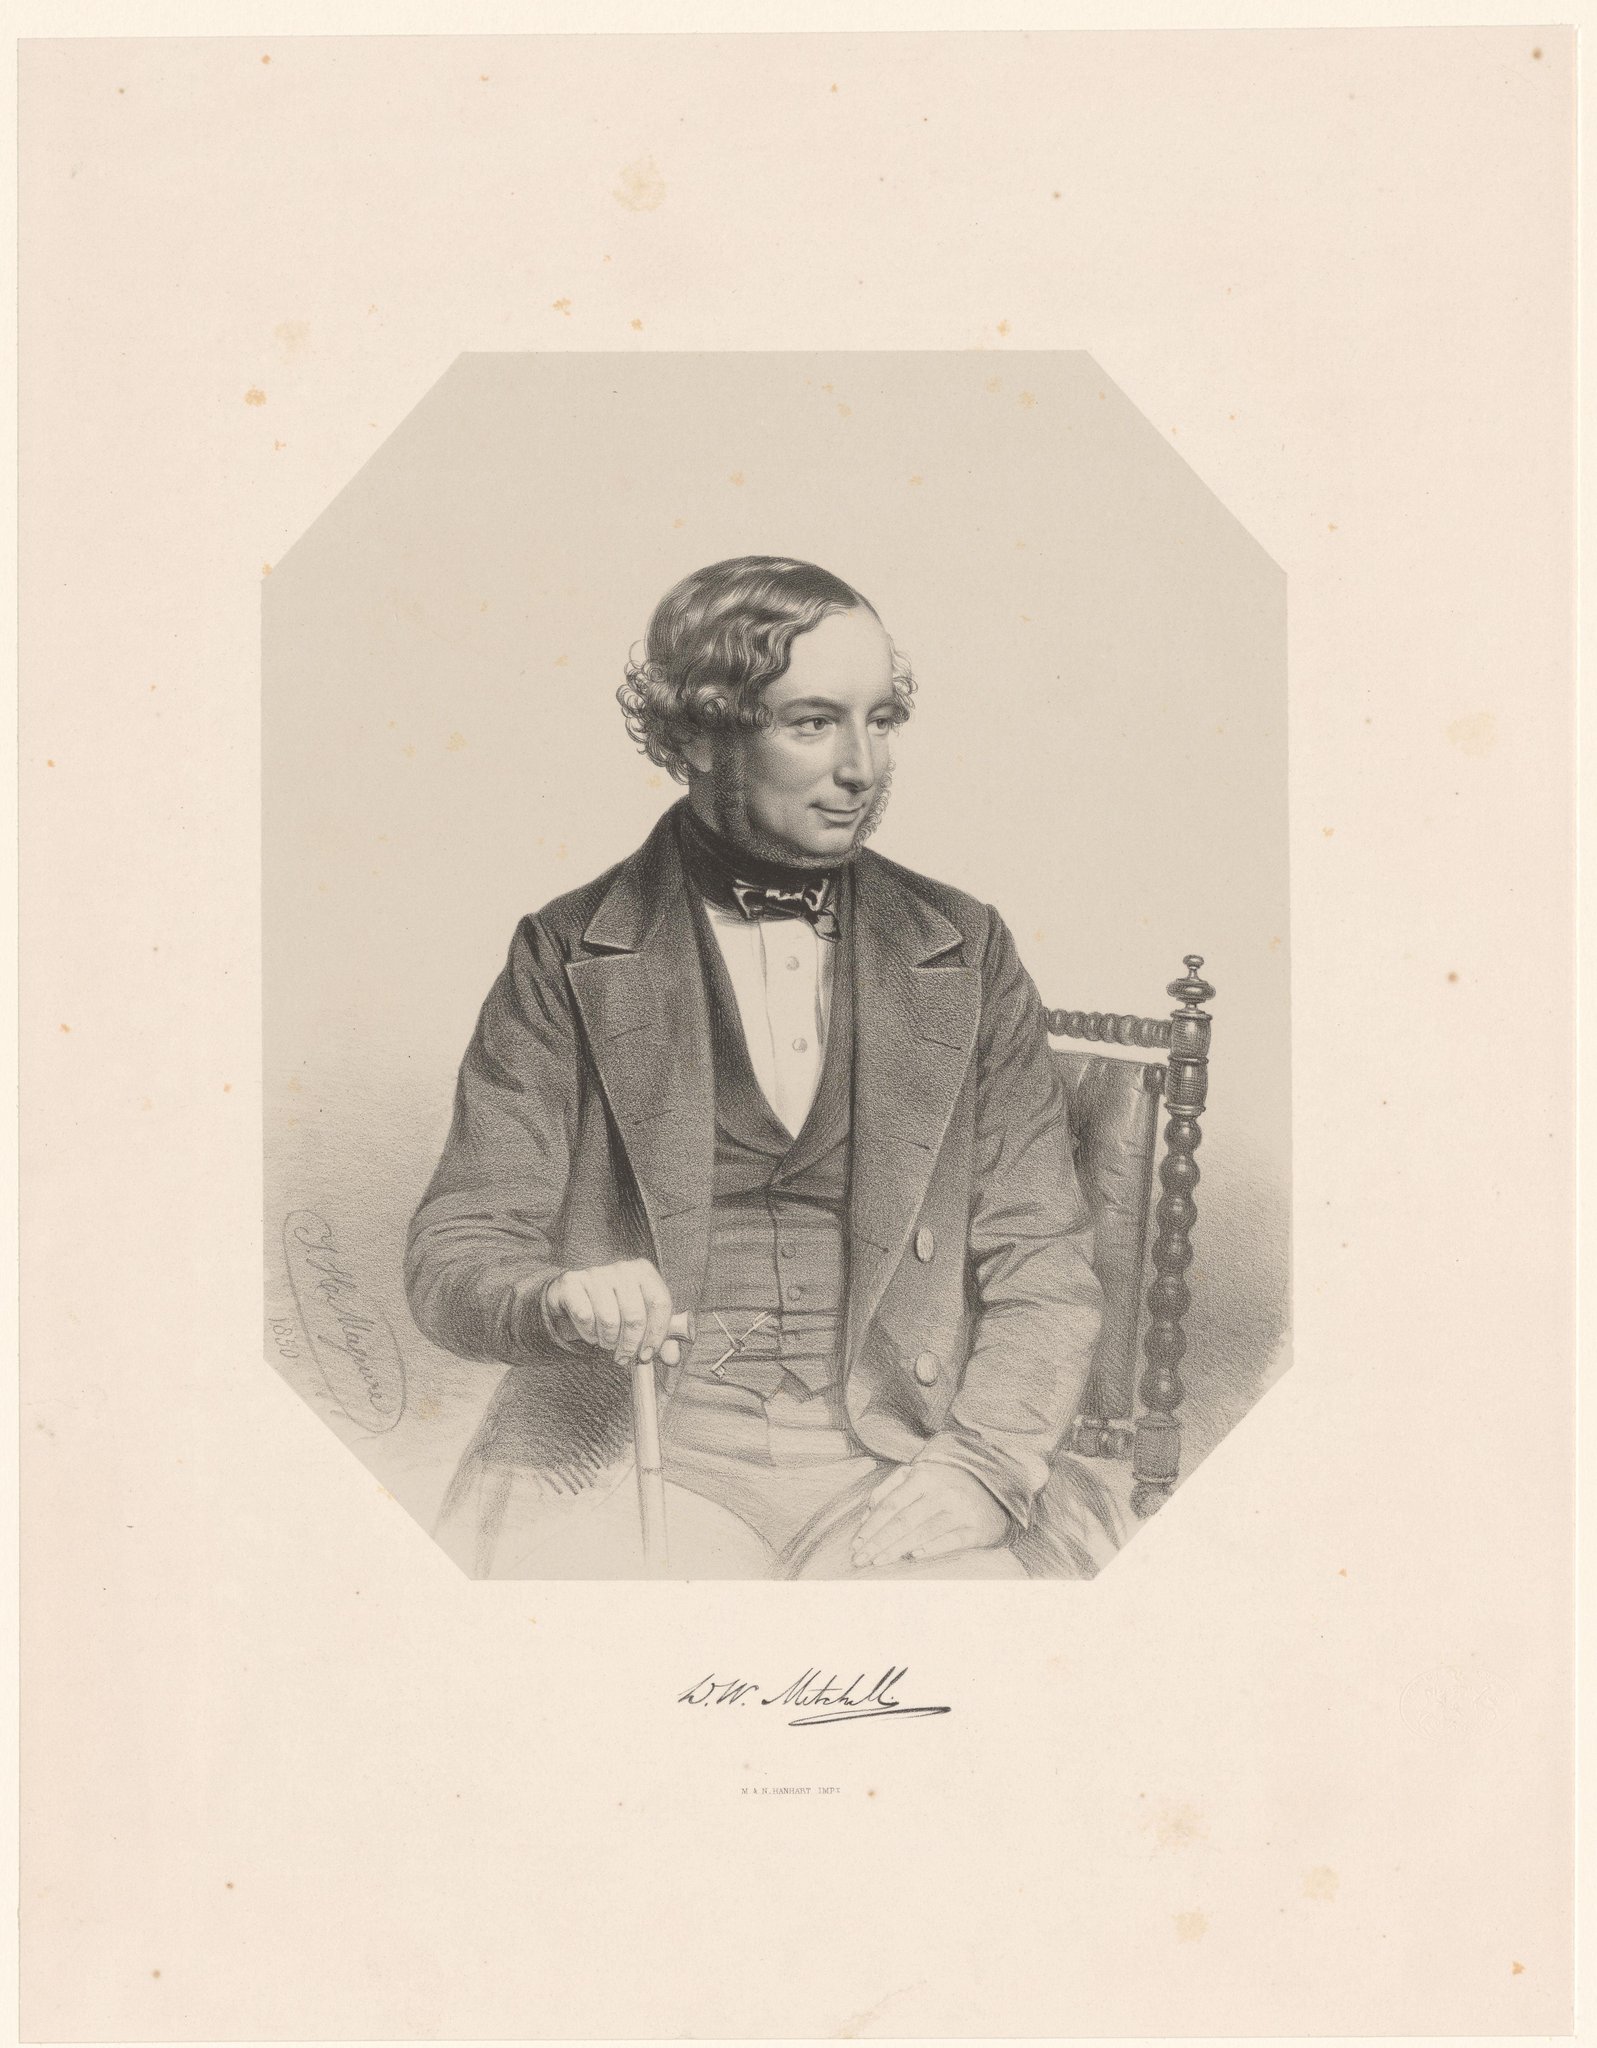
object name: print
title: Ipswich Museum Portraits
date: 1852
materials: paper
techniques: lithograph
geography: london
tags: walking-stick, staff, adult man, historical persons, chair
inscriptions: check stamp: ‘Ipswich Museum’, collector's mark: Lugt 2228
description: Prent behoort tot de serie 'Ipswich Museum Portraits', ook bekend onder de titel 'Portraits of Honorary Members of the Ipswich Museum'. Deze serie is in 1852 door George Ransome uitgegeven en gedrukt door M&N Hanhart tussen 1848 en 1852. De serie bestaat uit ca. 60 portretten.